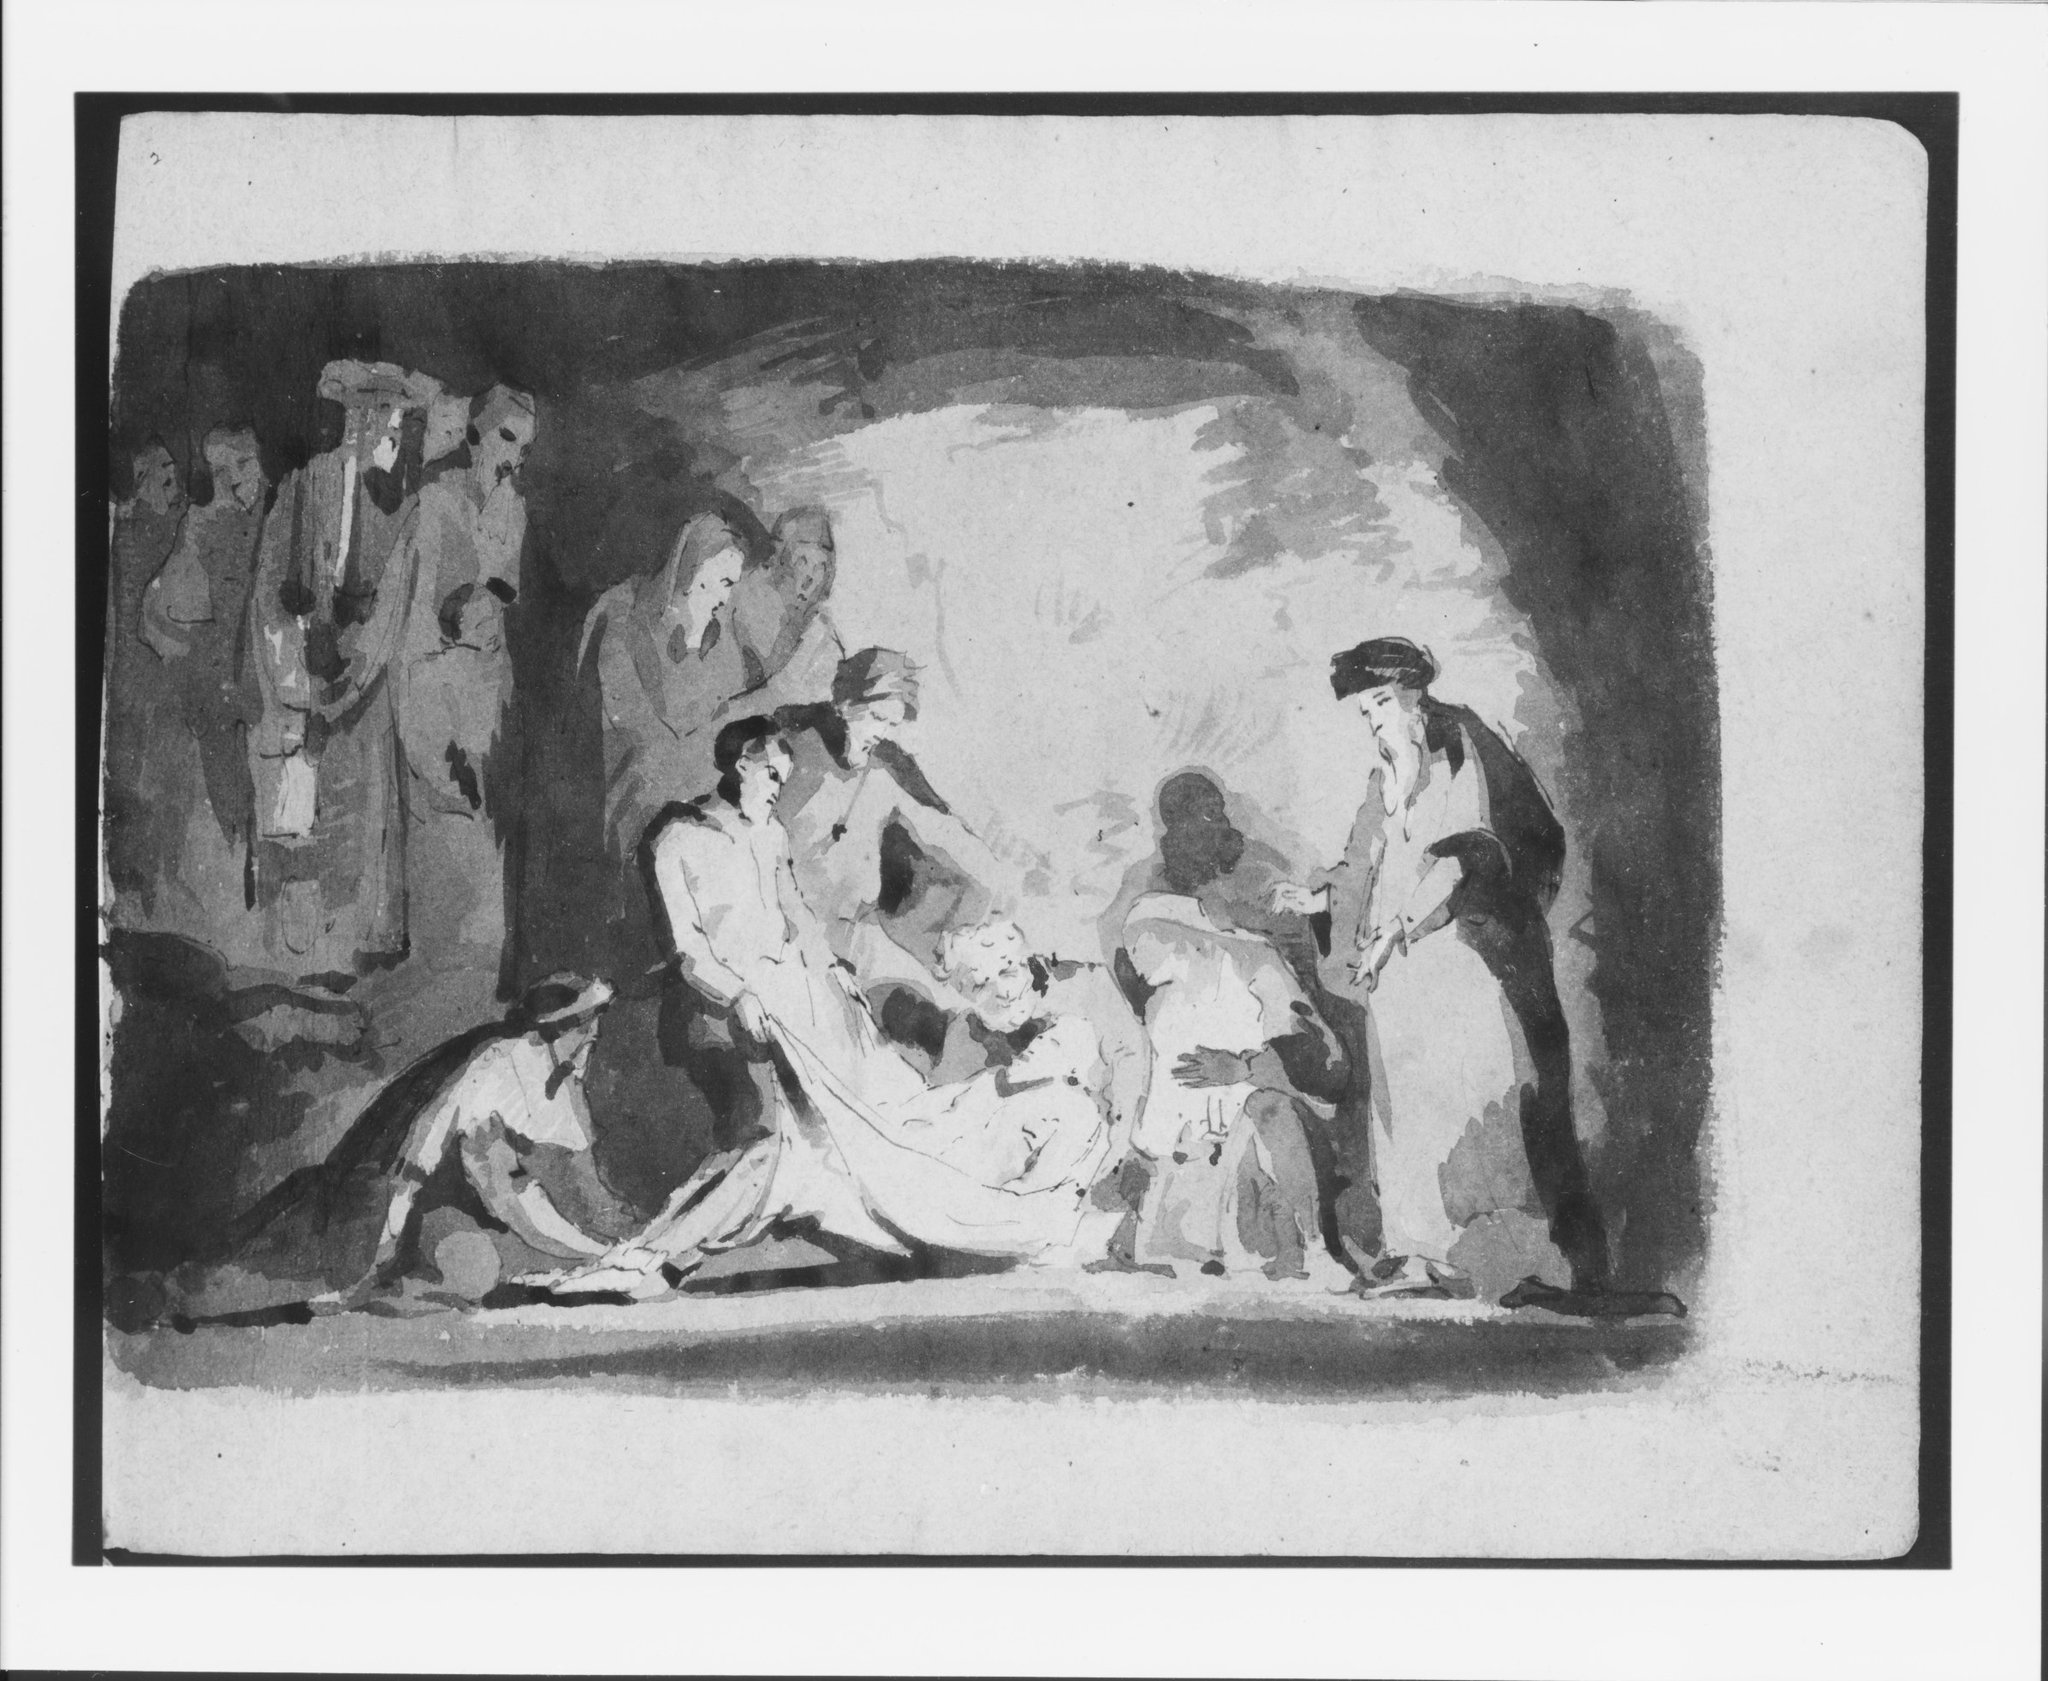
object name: drawing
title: Entombment (from Sketchbook)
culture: american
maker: thomas sully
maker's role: artist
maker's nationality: american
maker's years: 1783-1872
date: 1810-1820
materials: ink, paper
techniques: wash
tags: men,entombment